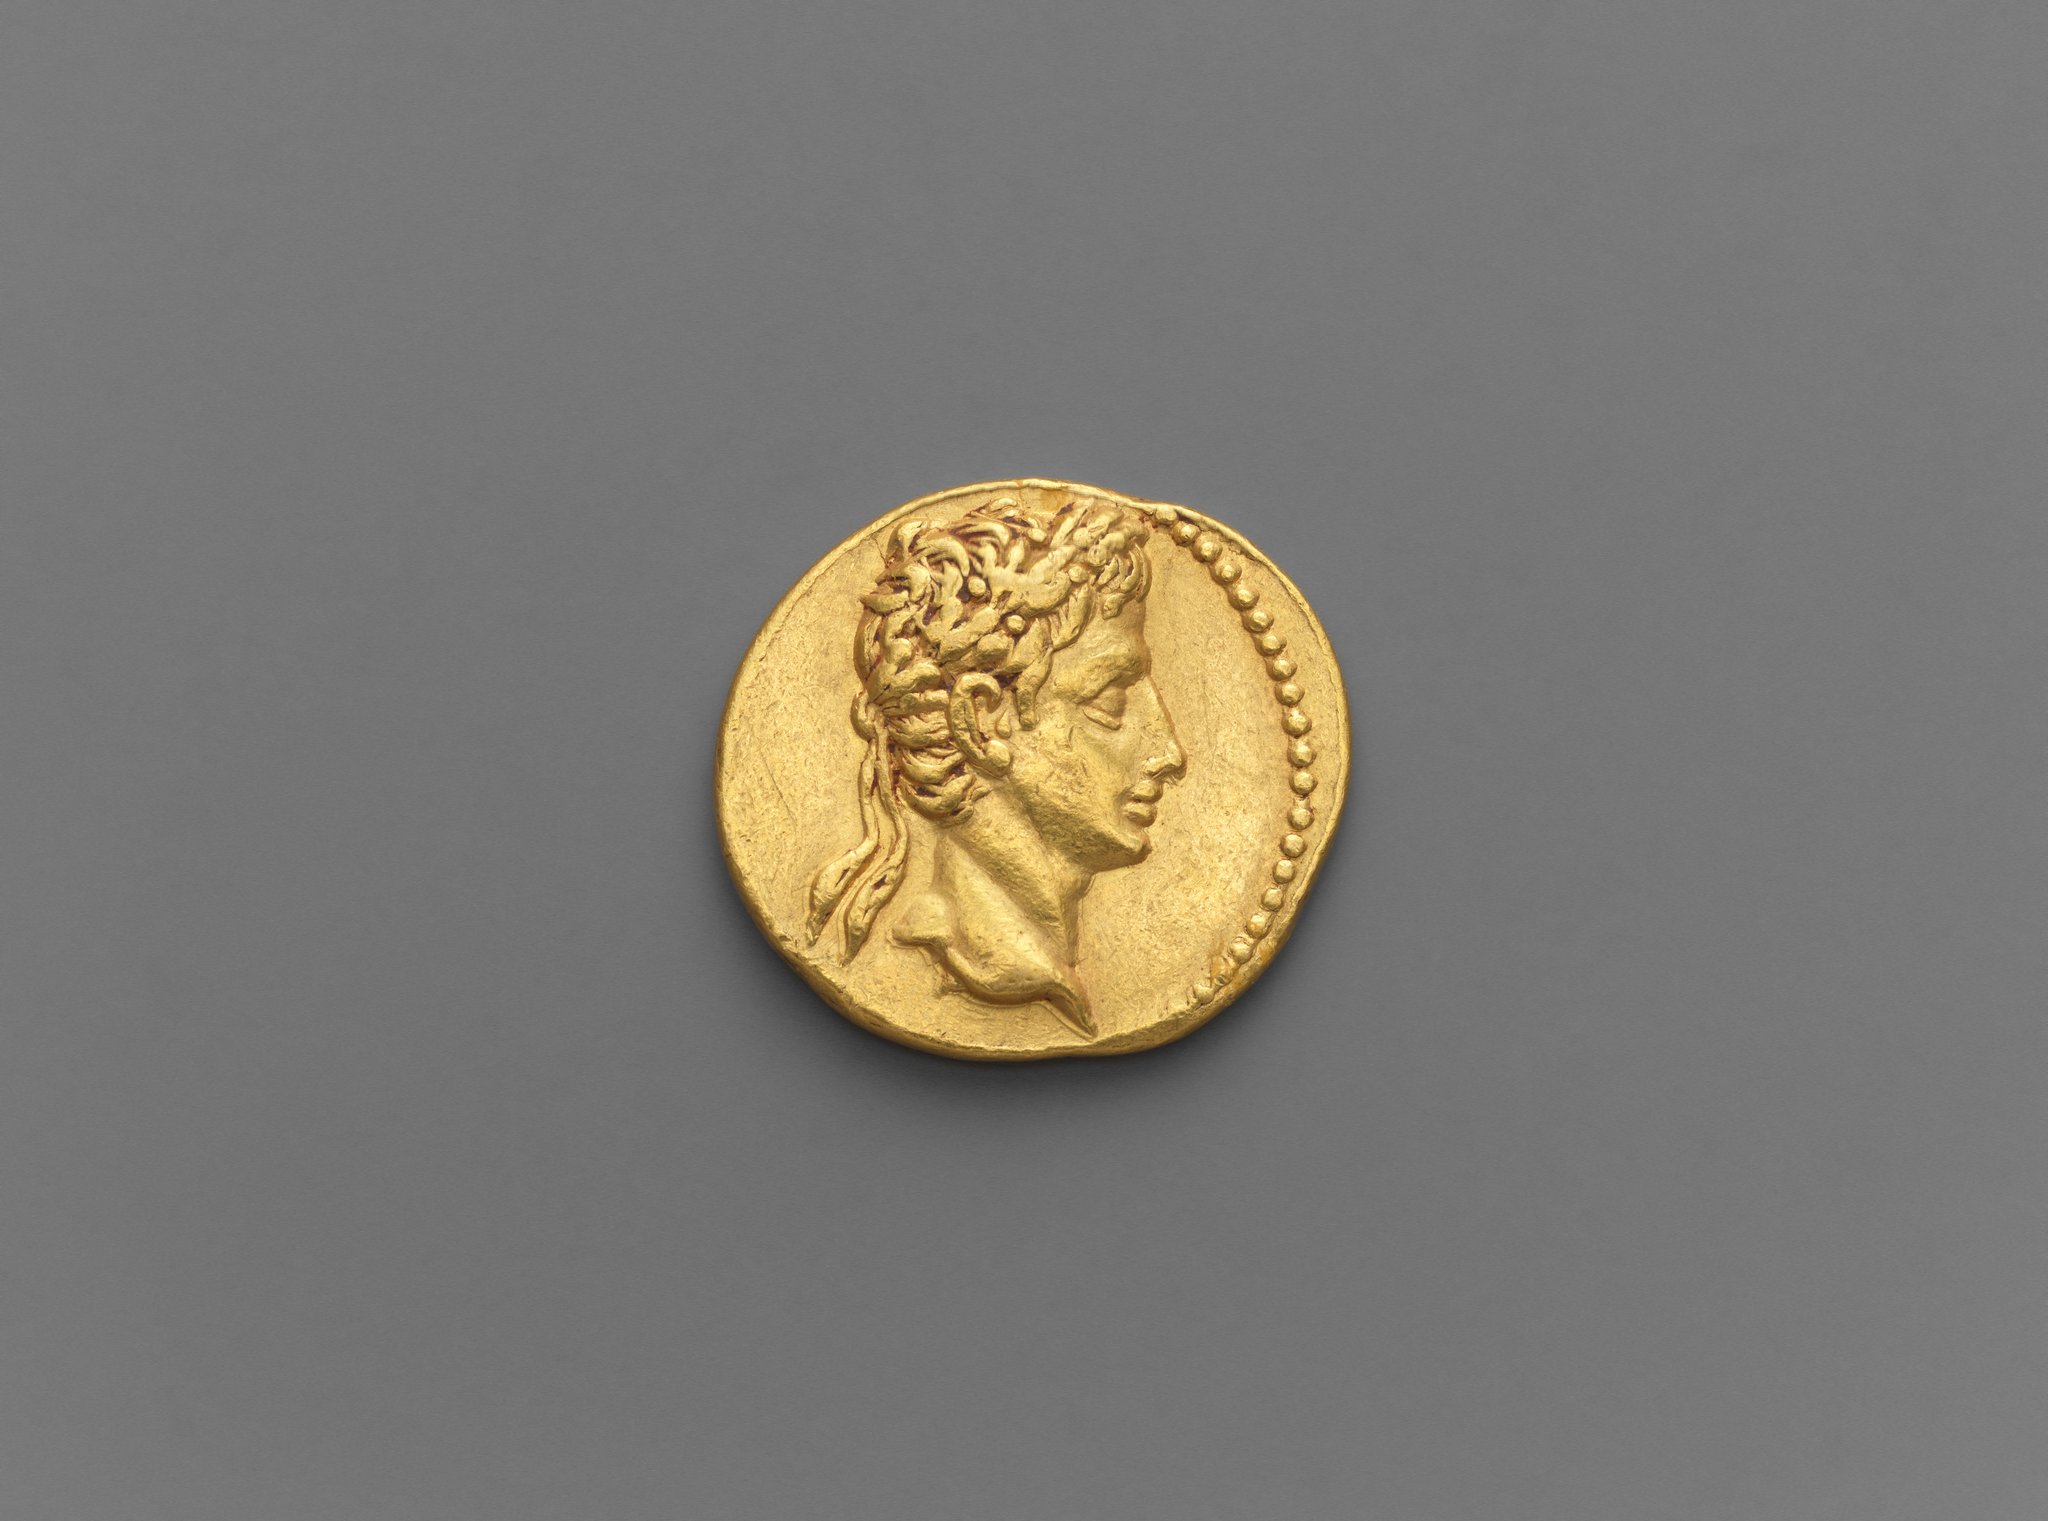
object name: aureus of augustus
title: Gold aureus of Augustus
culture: roman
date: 20-19 BCE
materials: gold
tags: emperor augustus,profiles,coins